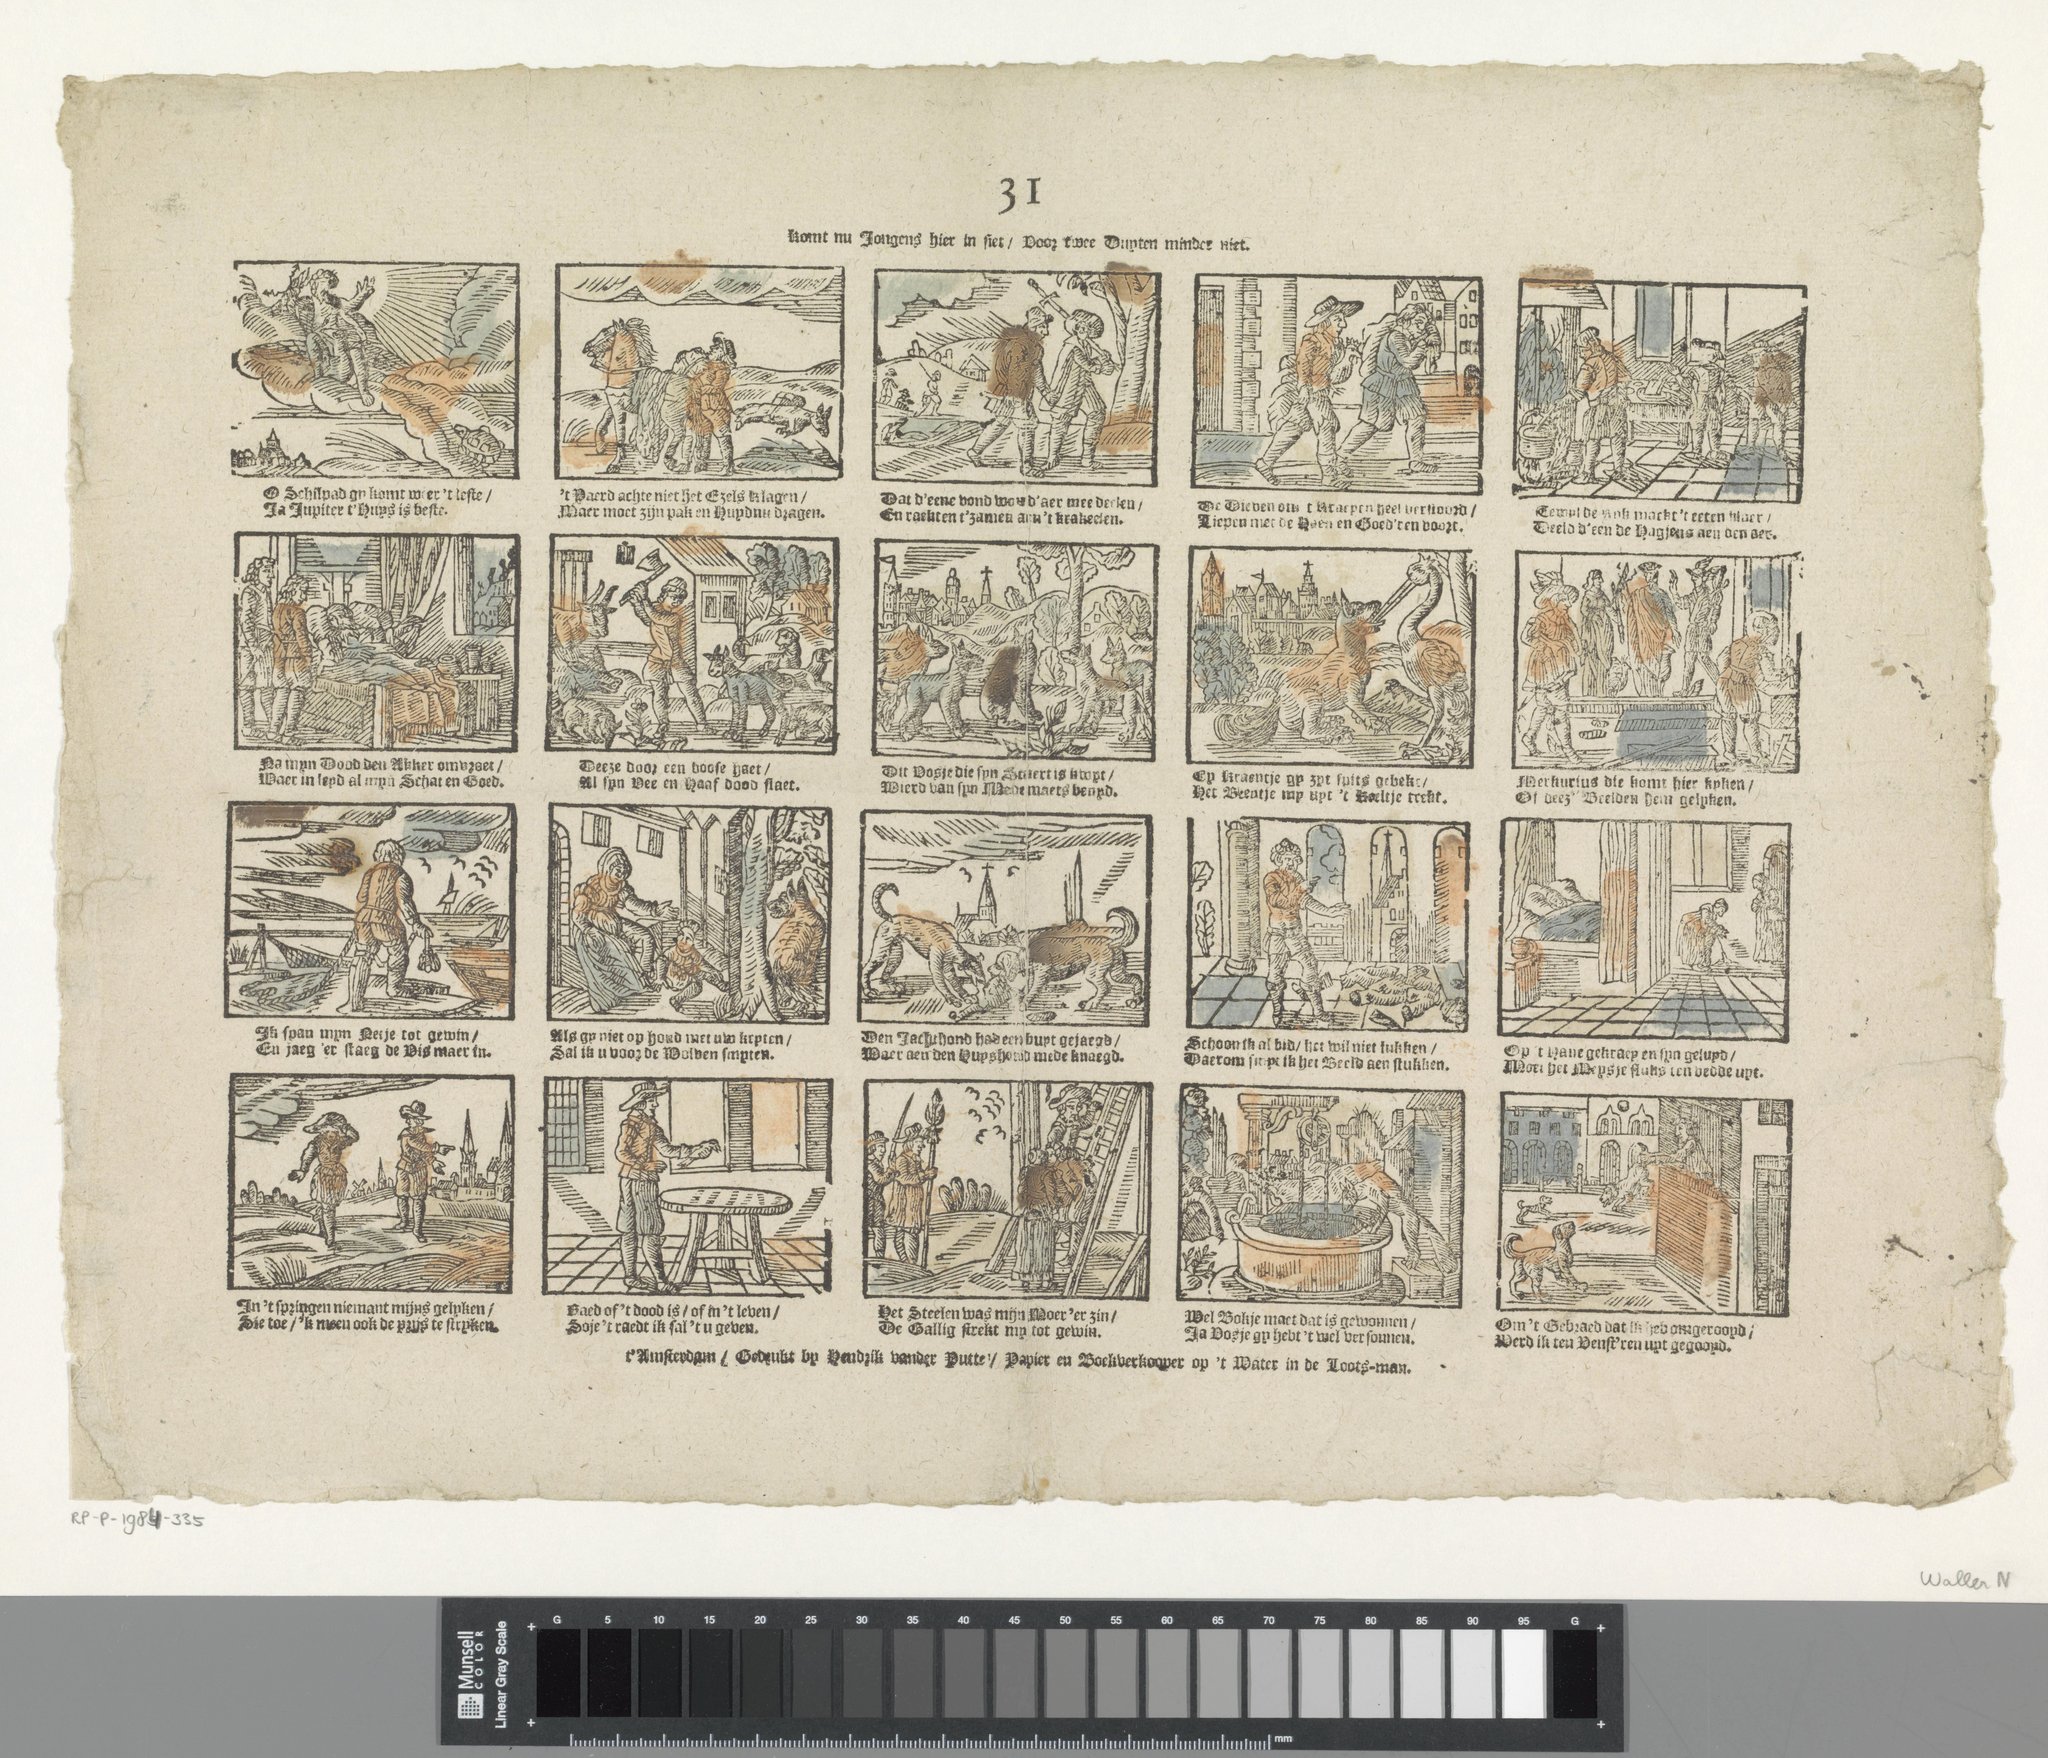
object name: popular print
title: Komt nu Jongens hier in siet / Voor twee duyten minder niet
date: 1761-1765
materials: paper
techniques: colour, letterpress printing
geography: amsterdam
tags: 'mundus inversus', the reversed world, the topsy-turvy world, 'le monde bestourné', fables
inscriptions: collector's mark: Lugt 2228, collector's mark: Lugt 2760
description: Blad met 20 voorstellingen van fabels. Onder elke afbeelding een tweeregelig vers. Genummerd midden boven: 31.